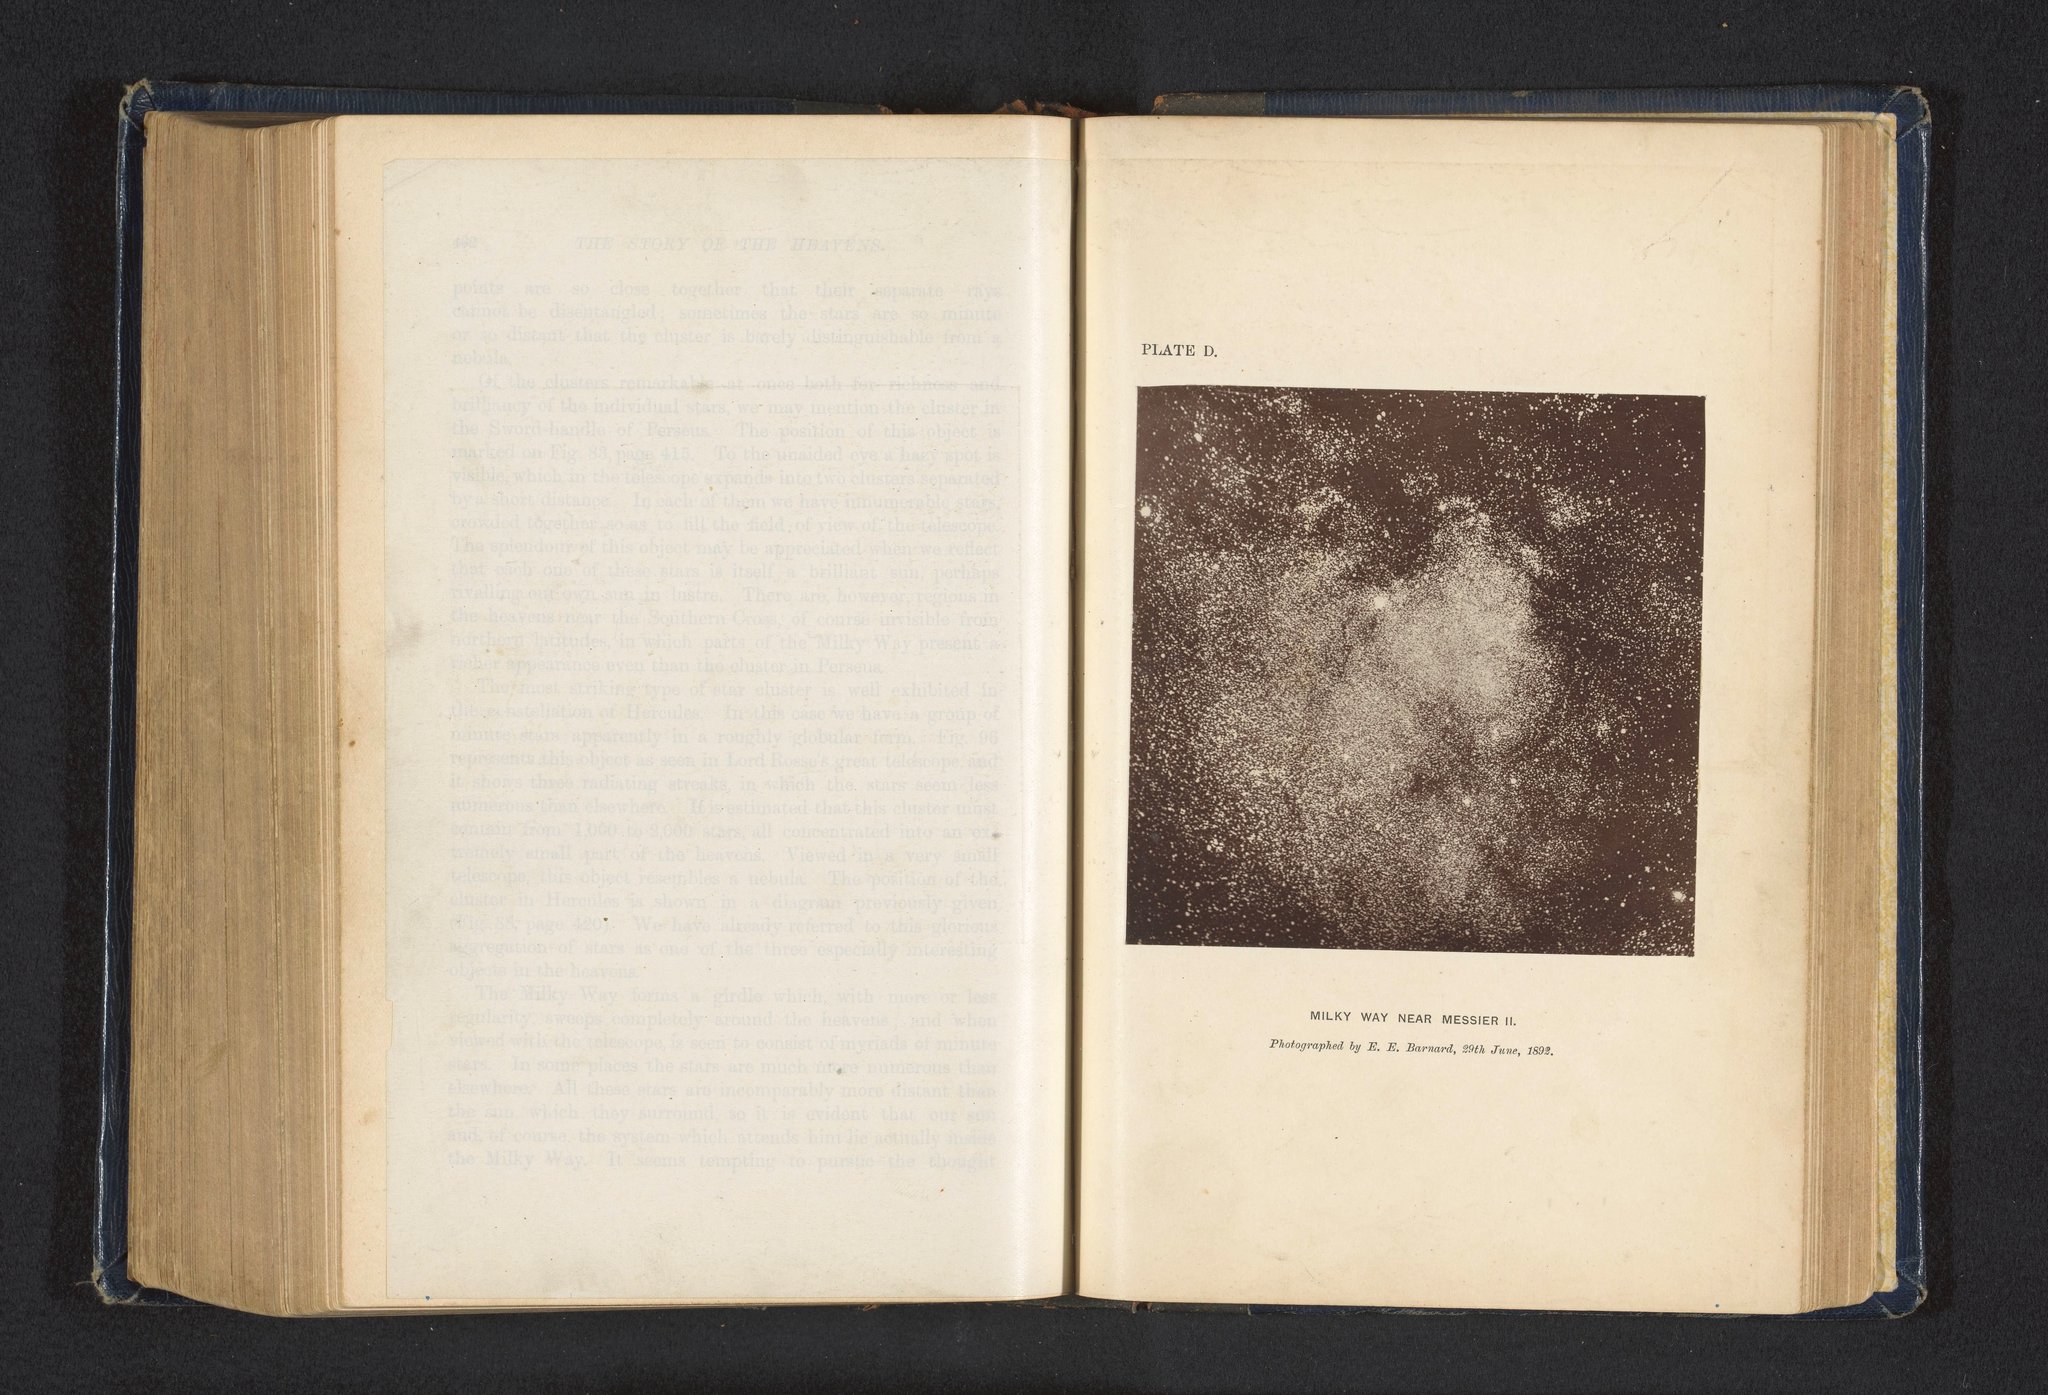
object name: photomechanical print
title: Milky way near Messier II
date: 1892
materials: paper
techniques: woodburytype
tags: milky way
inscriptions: number: ‘Plate D.’